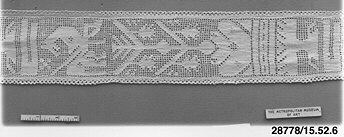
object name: swaddling band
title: Swaddling bands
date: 1601-1700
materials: linen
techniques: embroidery